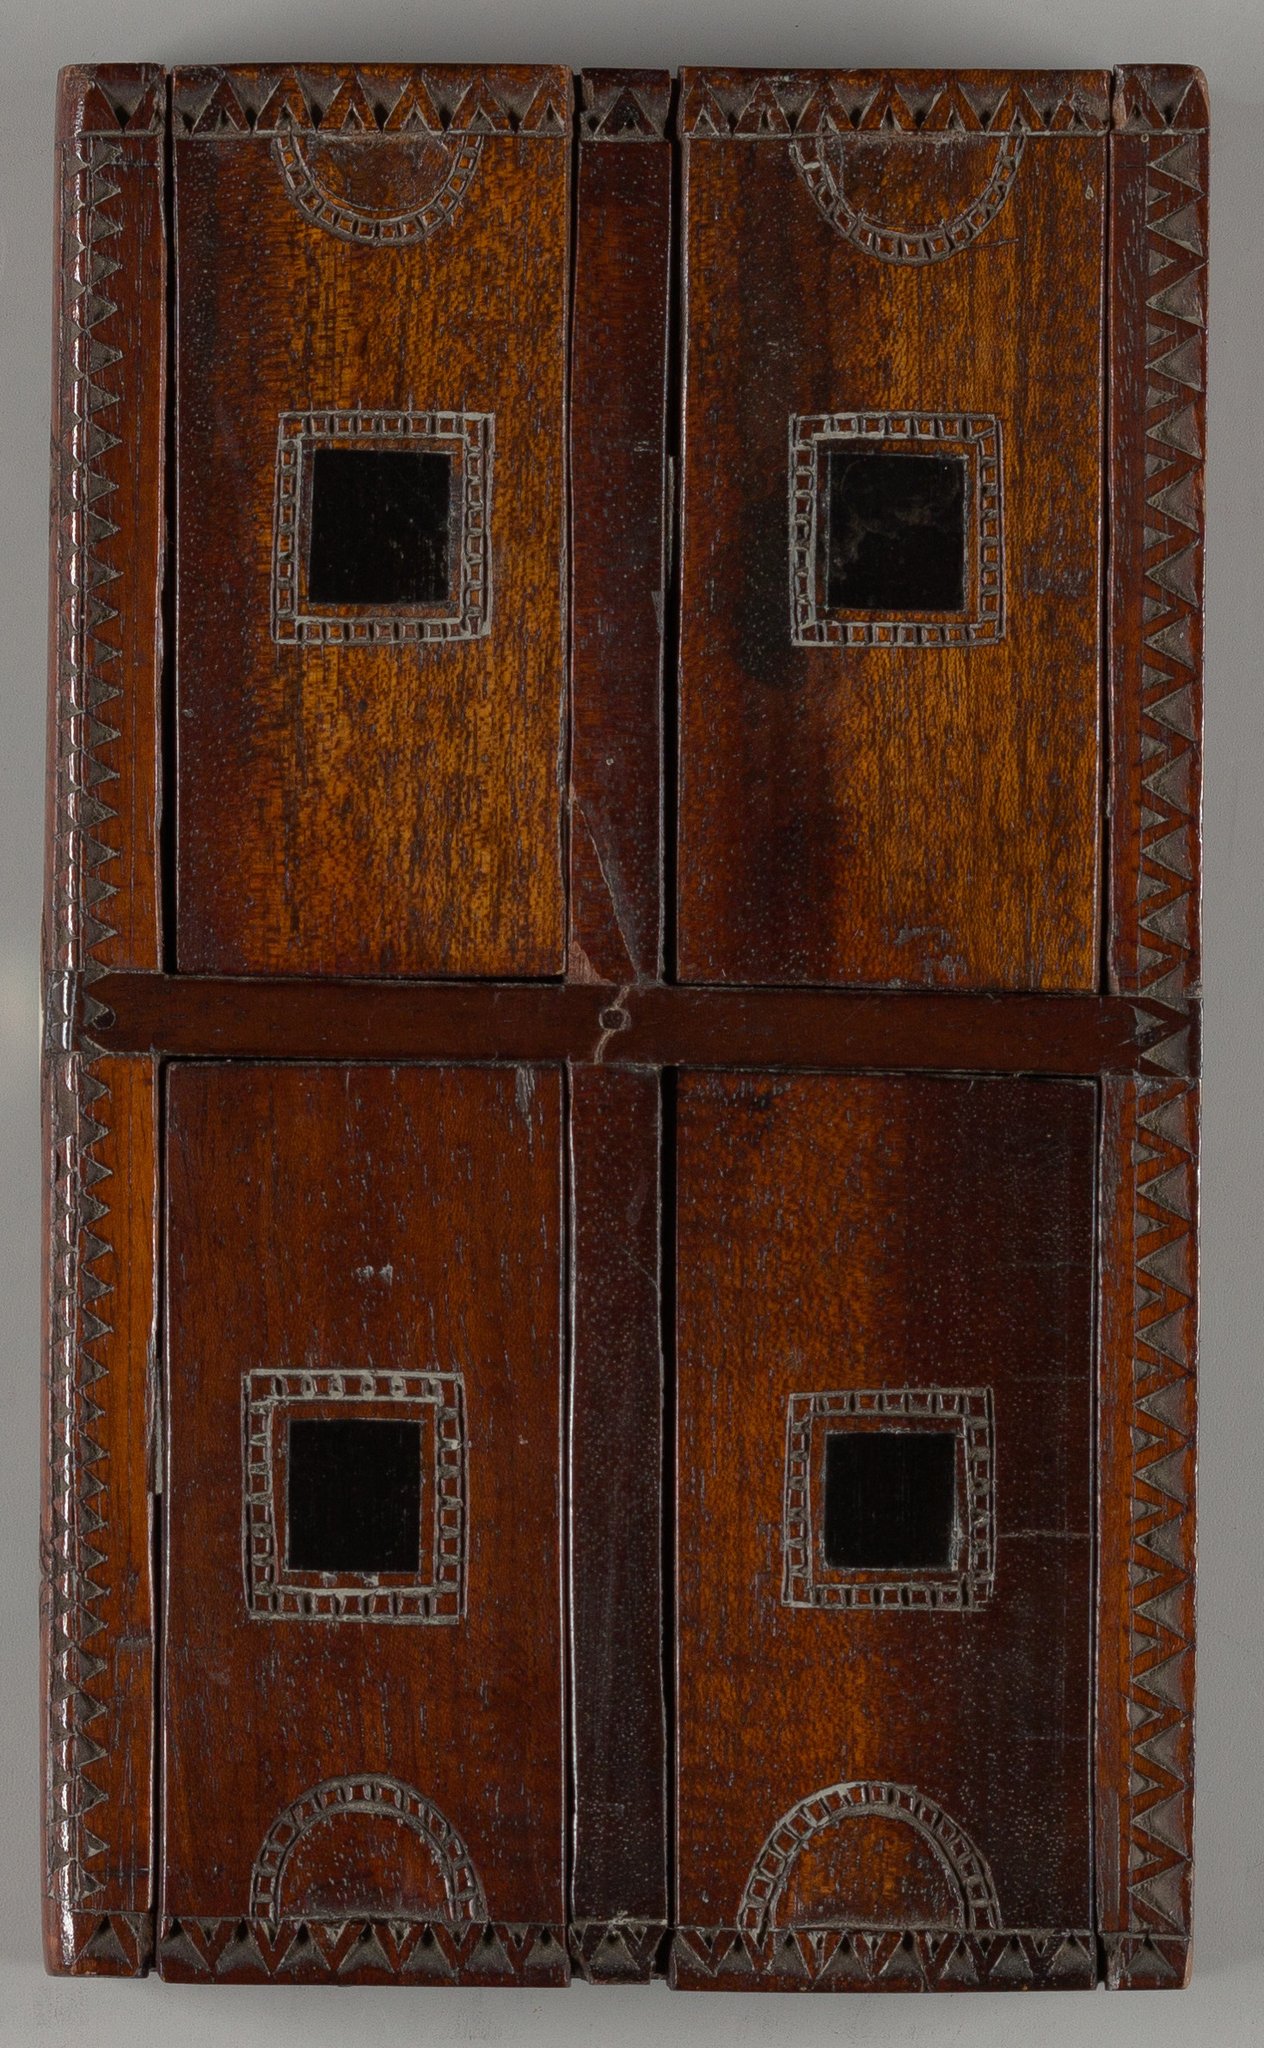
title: Box in book form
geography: europe